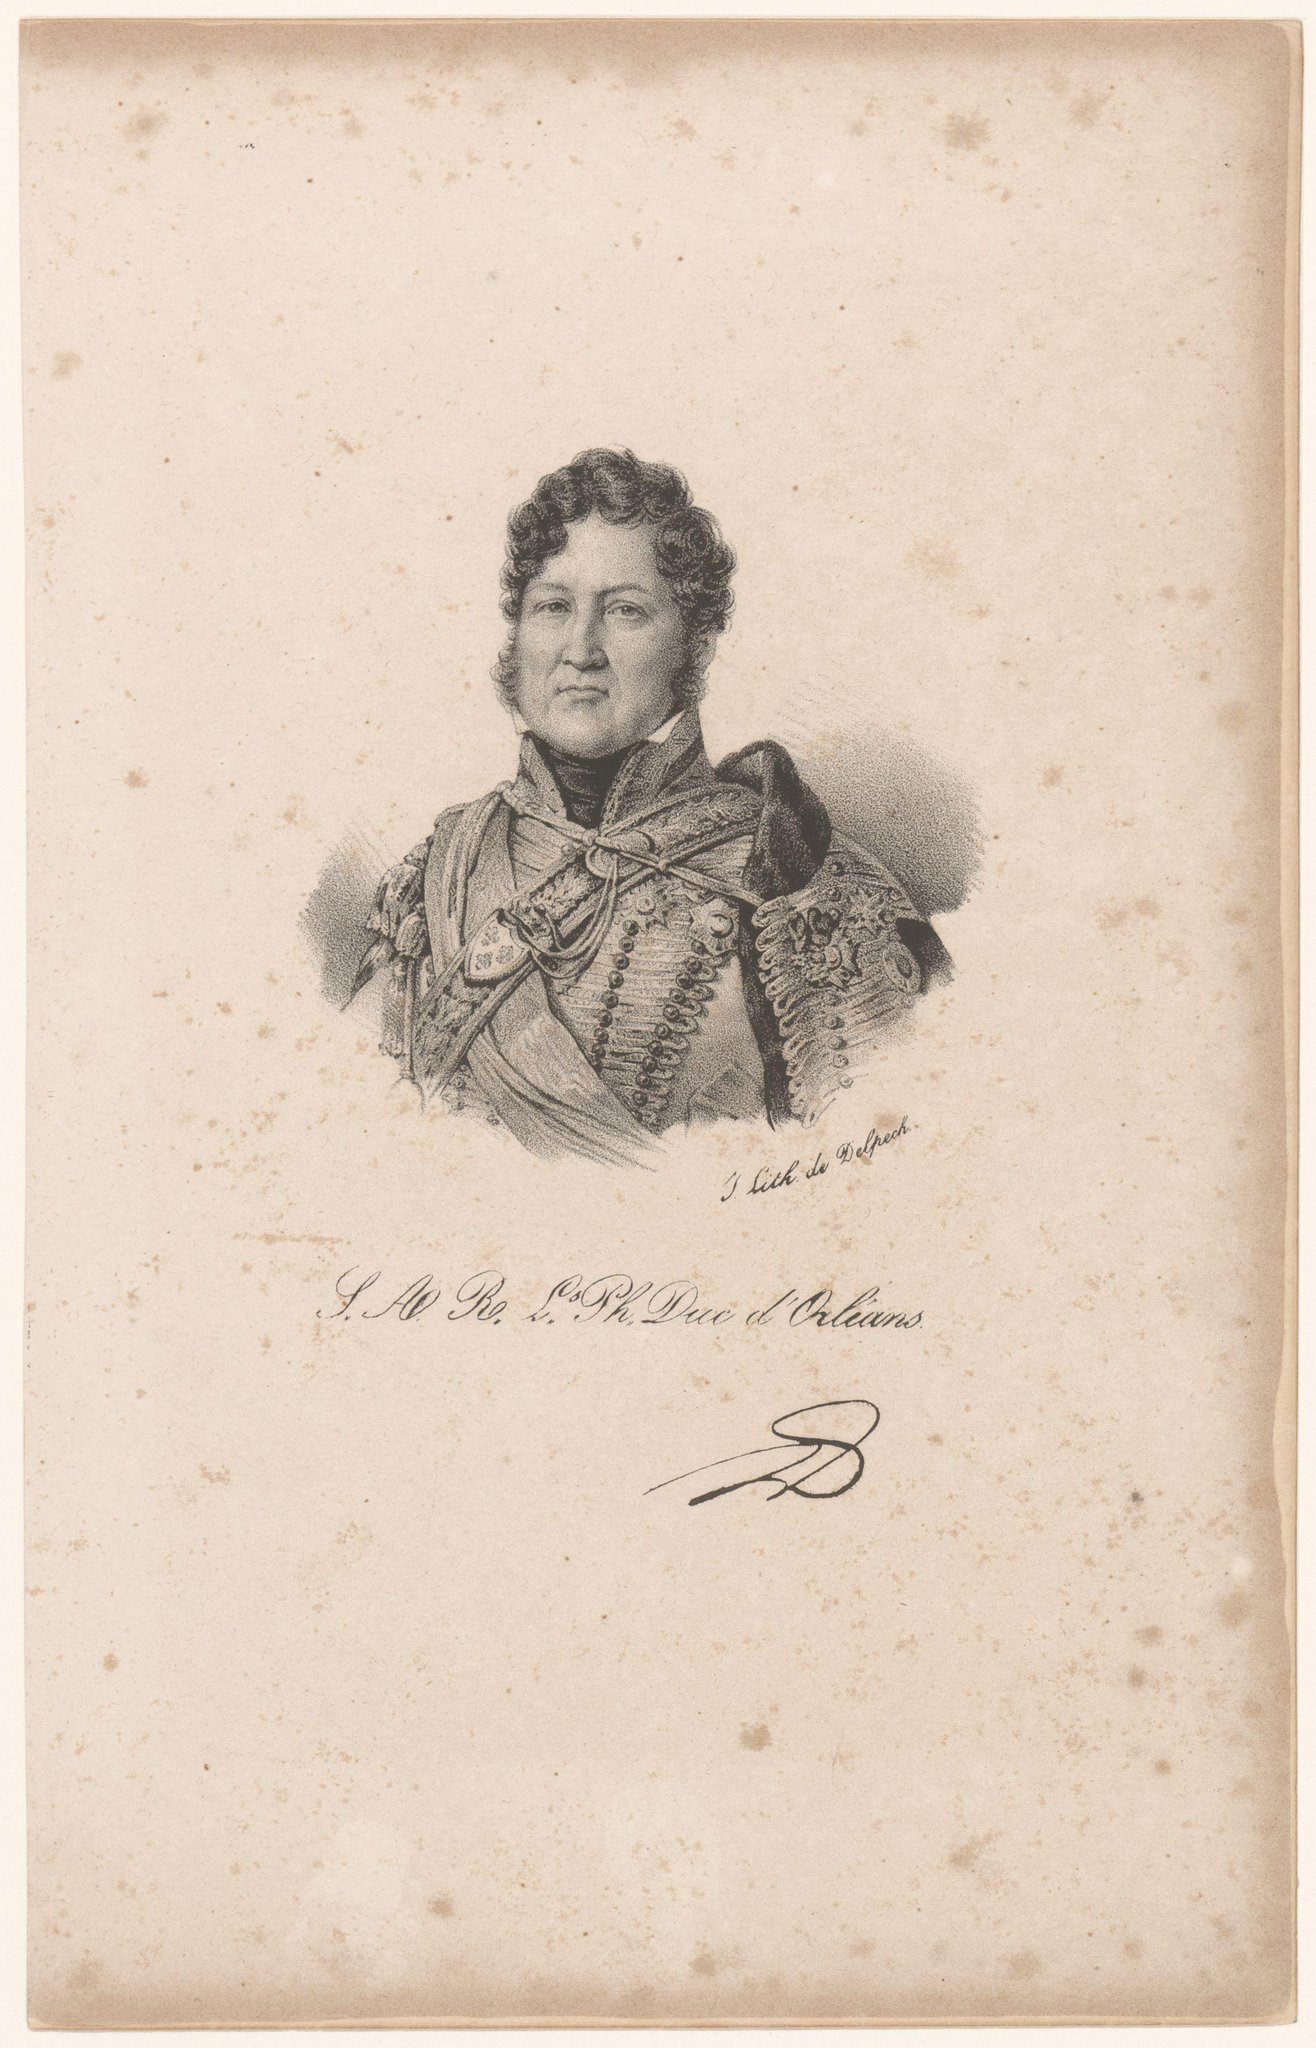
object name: print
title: S.A.R. L.s Ph. Duc d'Orléans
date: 1818-1842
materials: paper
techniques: lithograph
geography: paris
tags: paris, lodewijk filips i (koning van frankrijk), historical persons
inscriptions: collector's mark: Lugt 2228a